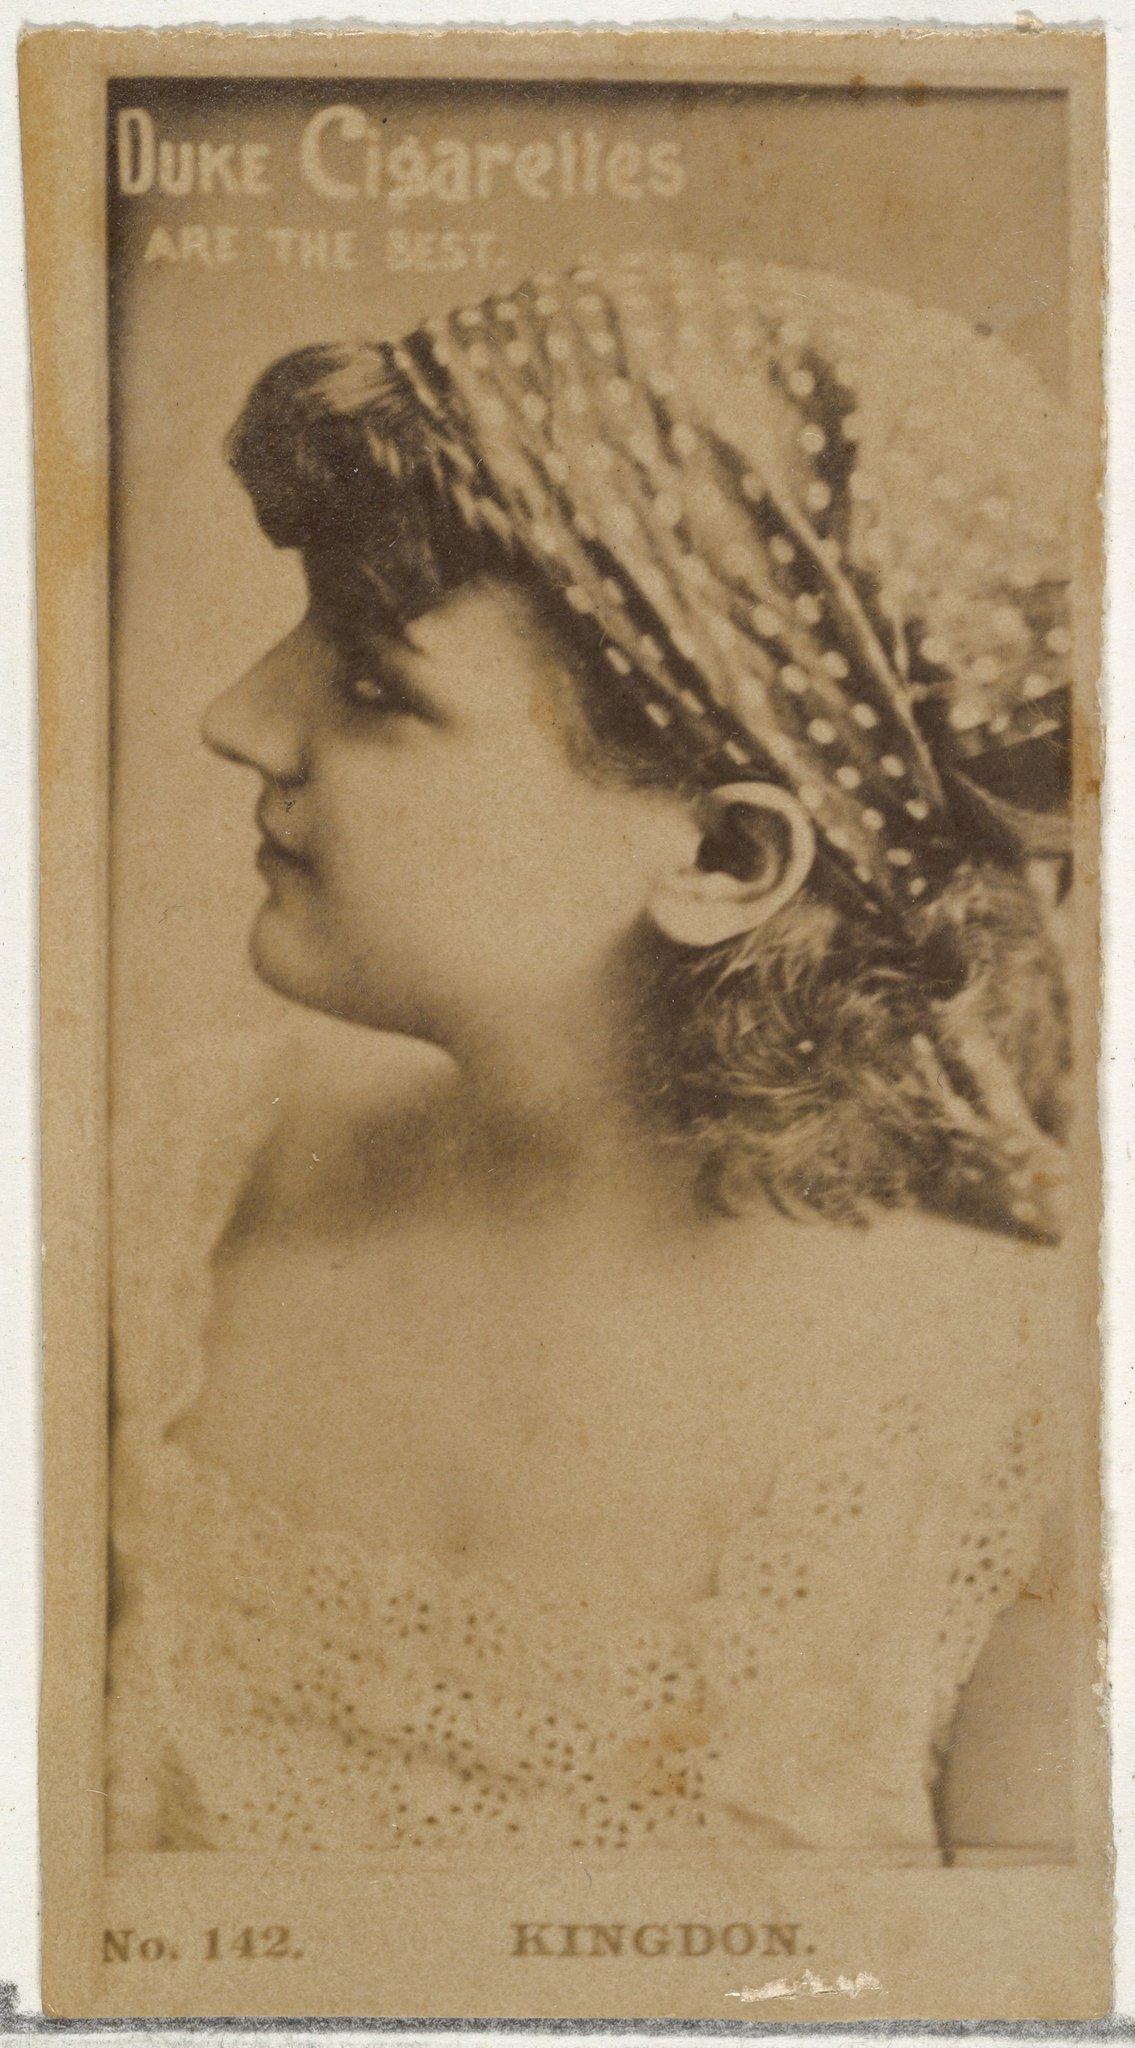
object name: photograph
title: Card Number 142, Miss Kingdon, from the Actors and Actresses series (N145-6) issued by Duke Sons & Co. to promote Duke Cigarettes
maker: w. duke, sons & co.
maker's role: publisher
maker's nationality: american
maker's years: 1870-1920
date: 1880-1889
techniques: albumen silver print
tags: women,actresses